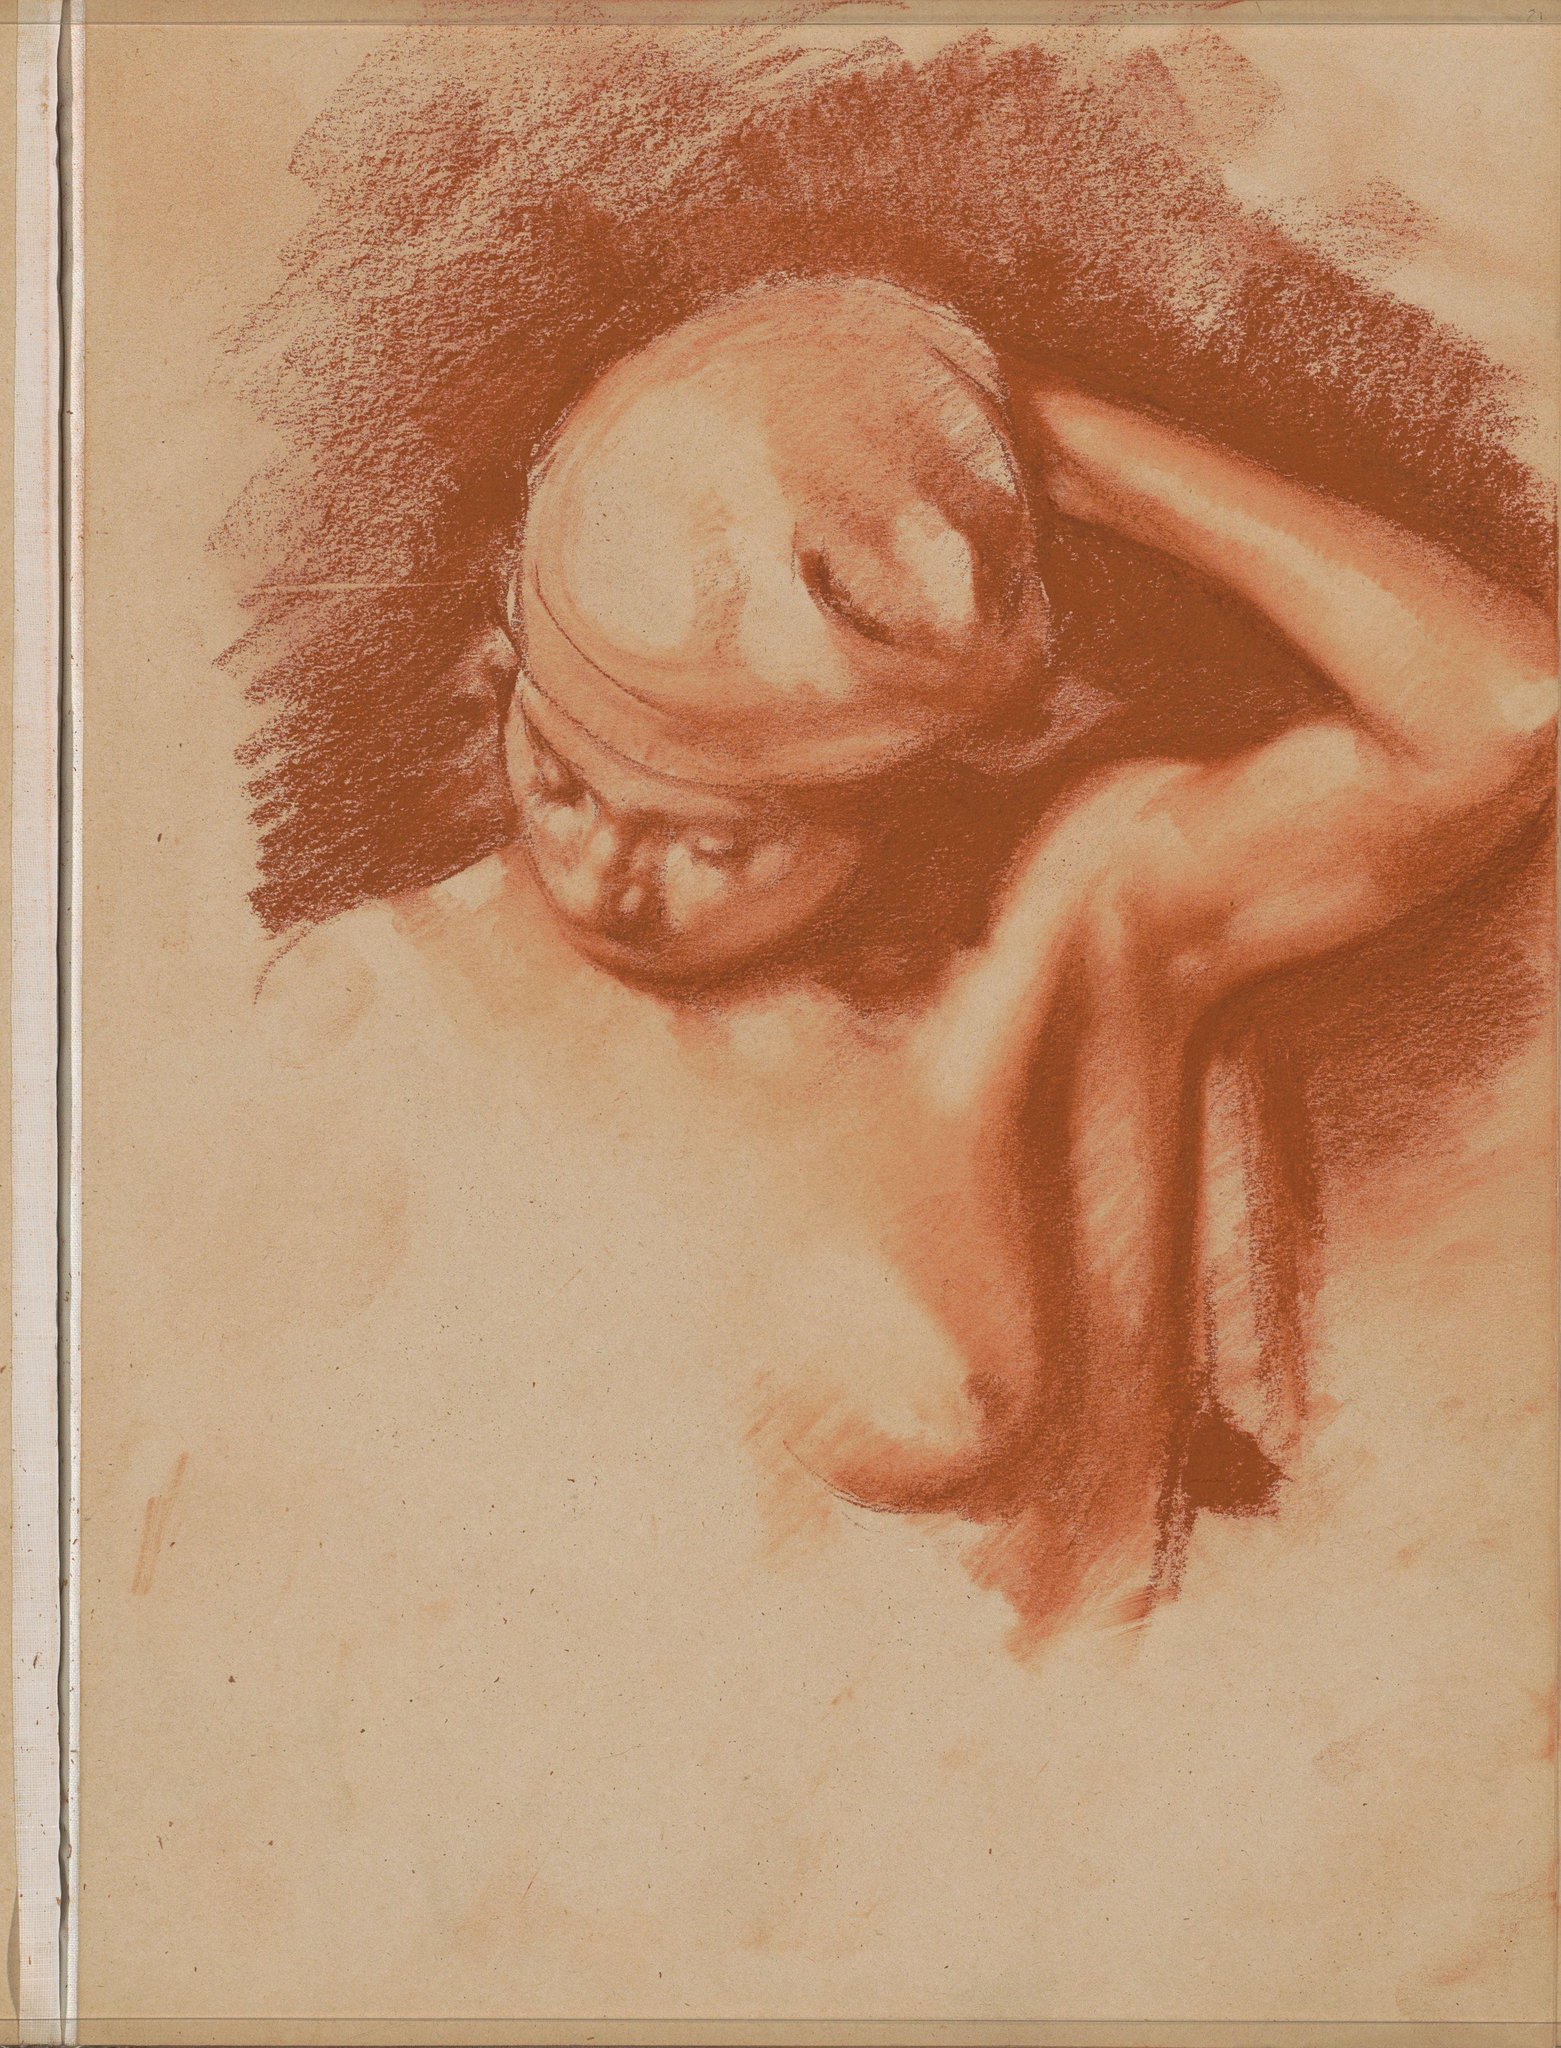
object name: sketchbook leaf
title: Vrouwelijk naakt met opgeheven linkerarm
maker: willem witsen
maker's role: draughtsman, painter, print maker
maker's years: 1860-1923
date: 1874-1923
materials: chalk, paper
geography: ewijkshoeve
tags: head-gear, hand(s) behind the head, the (nude) human figure; 'corpo humano' (ripa) - aa - female human figure (+ front view)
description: Met hoofdbedekking. Pagina 21 uit een schetsboek met 72 bladen.